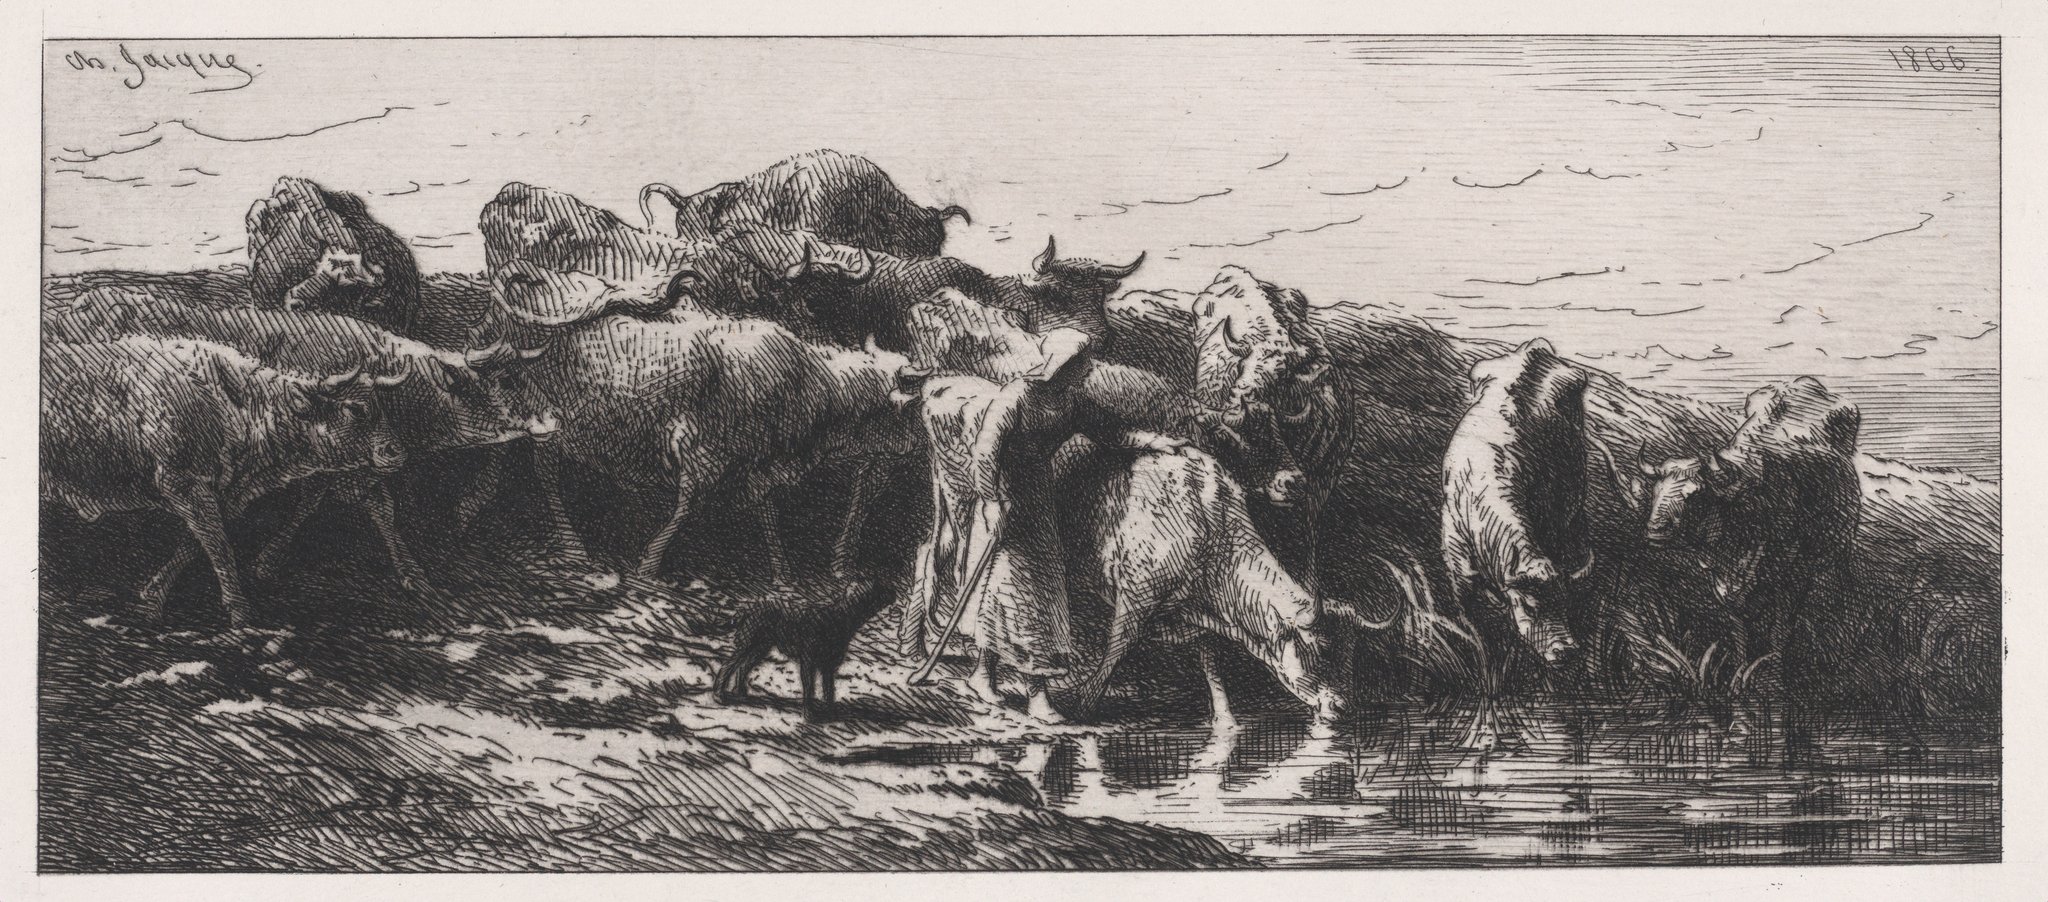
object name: print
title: L'Abreuvoir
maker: charles émile jacque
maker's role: artist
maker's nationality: french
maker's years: 1813-1894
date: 1866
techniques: drypoint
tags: cows